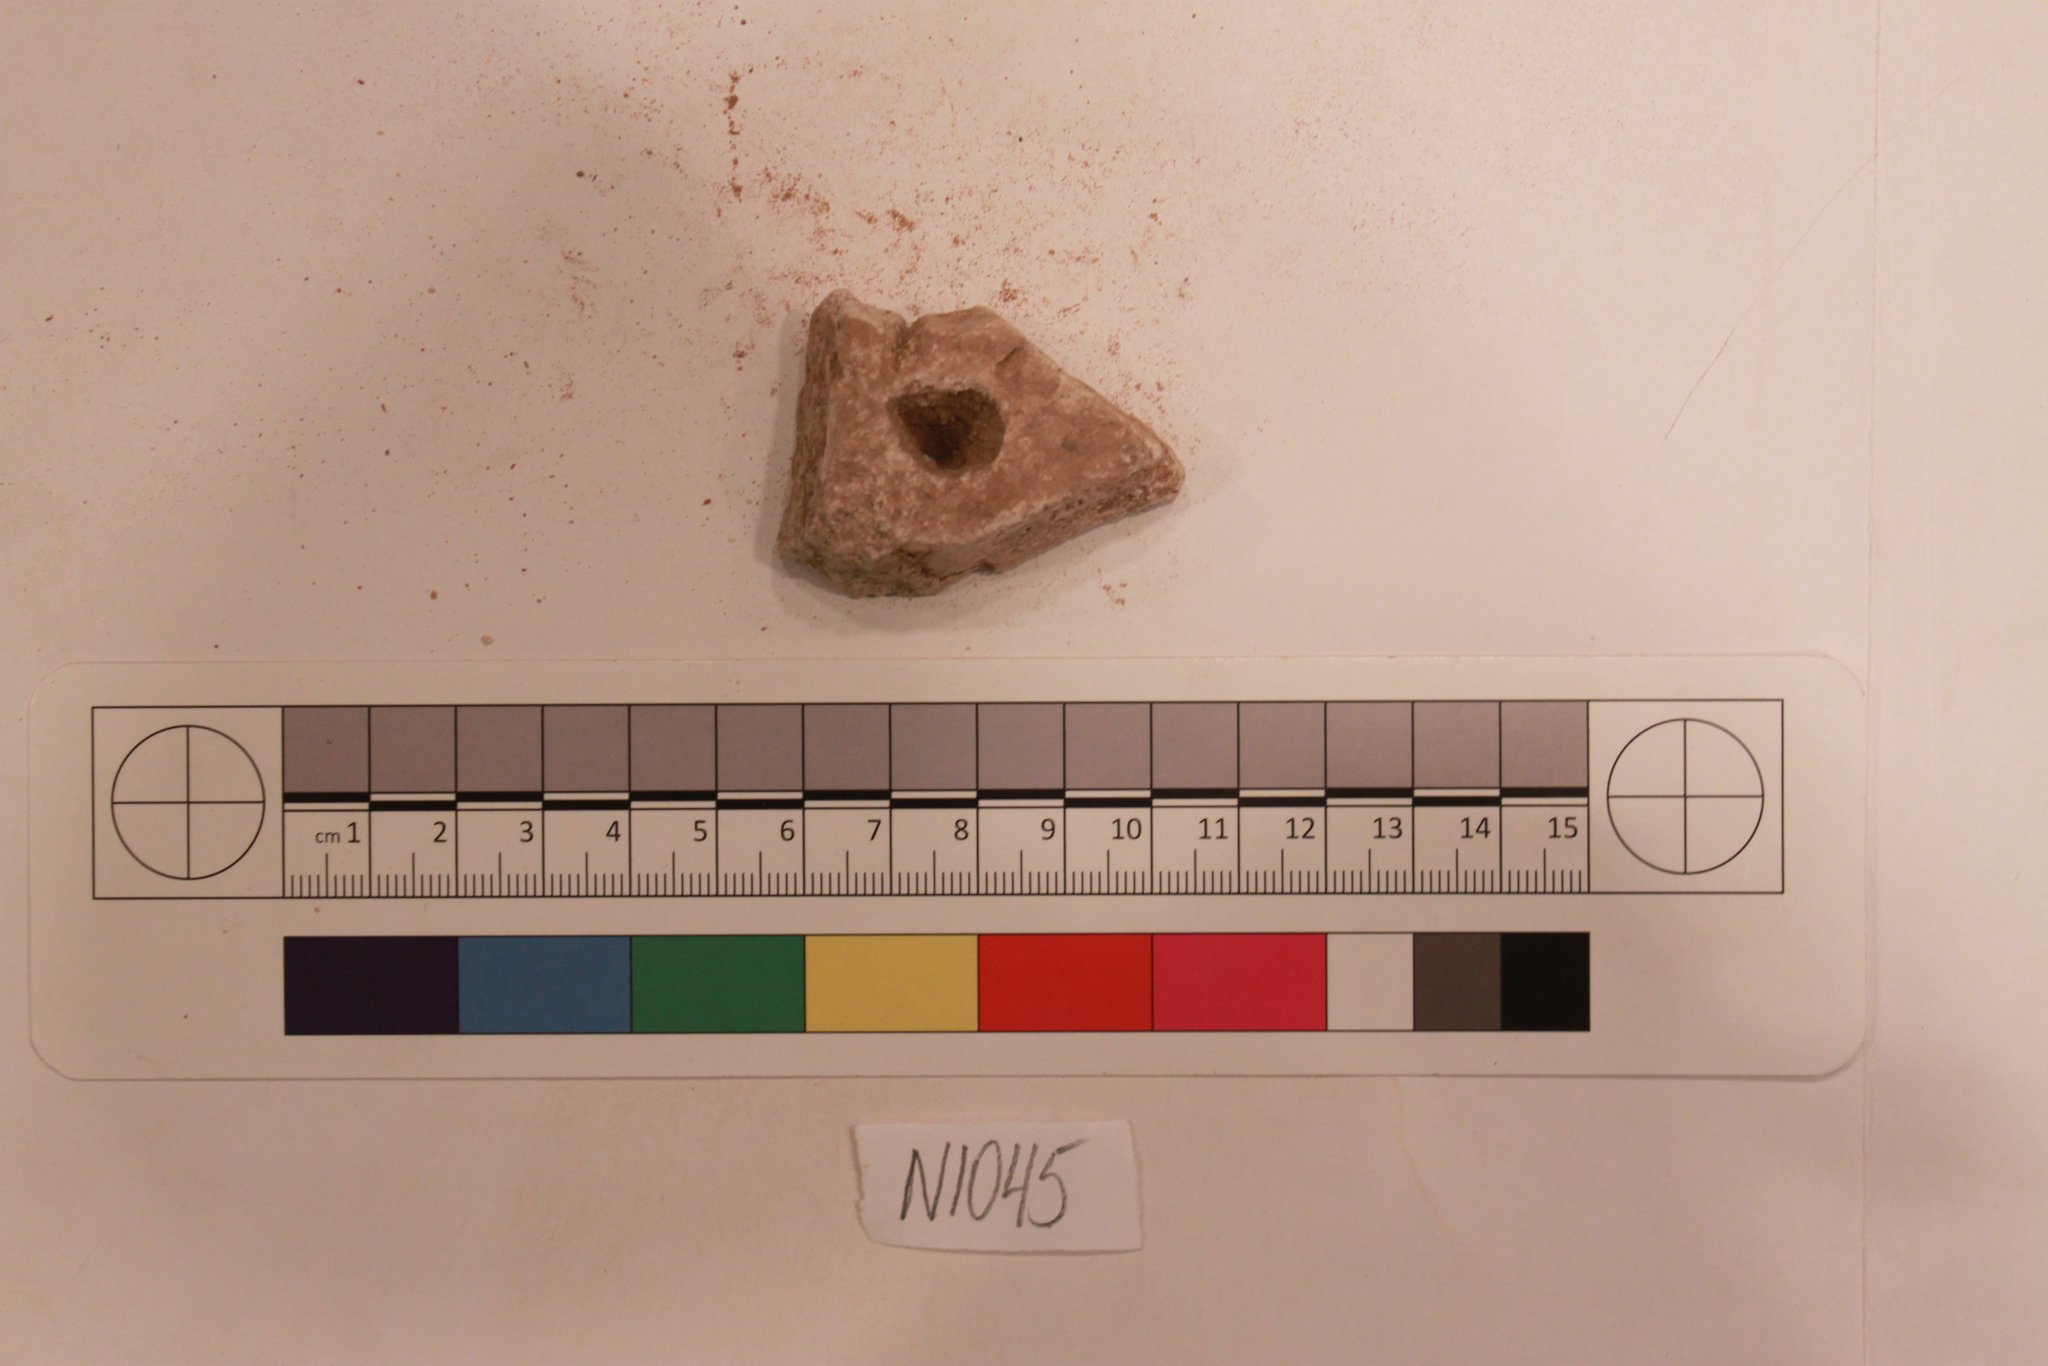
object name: fragment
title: Stucco Fragment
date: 701-1200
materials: plaster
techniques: carving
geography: iran